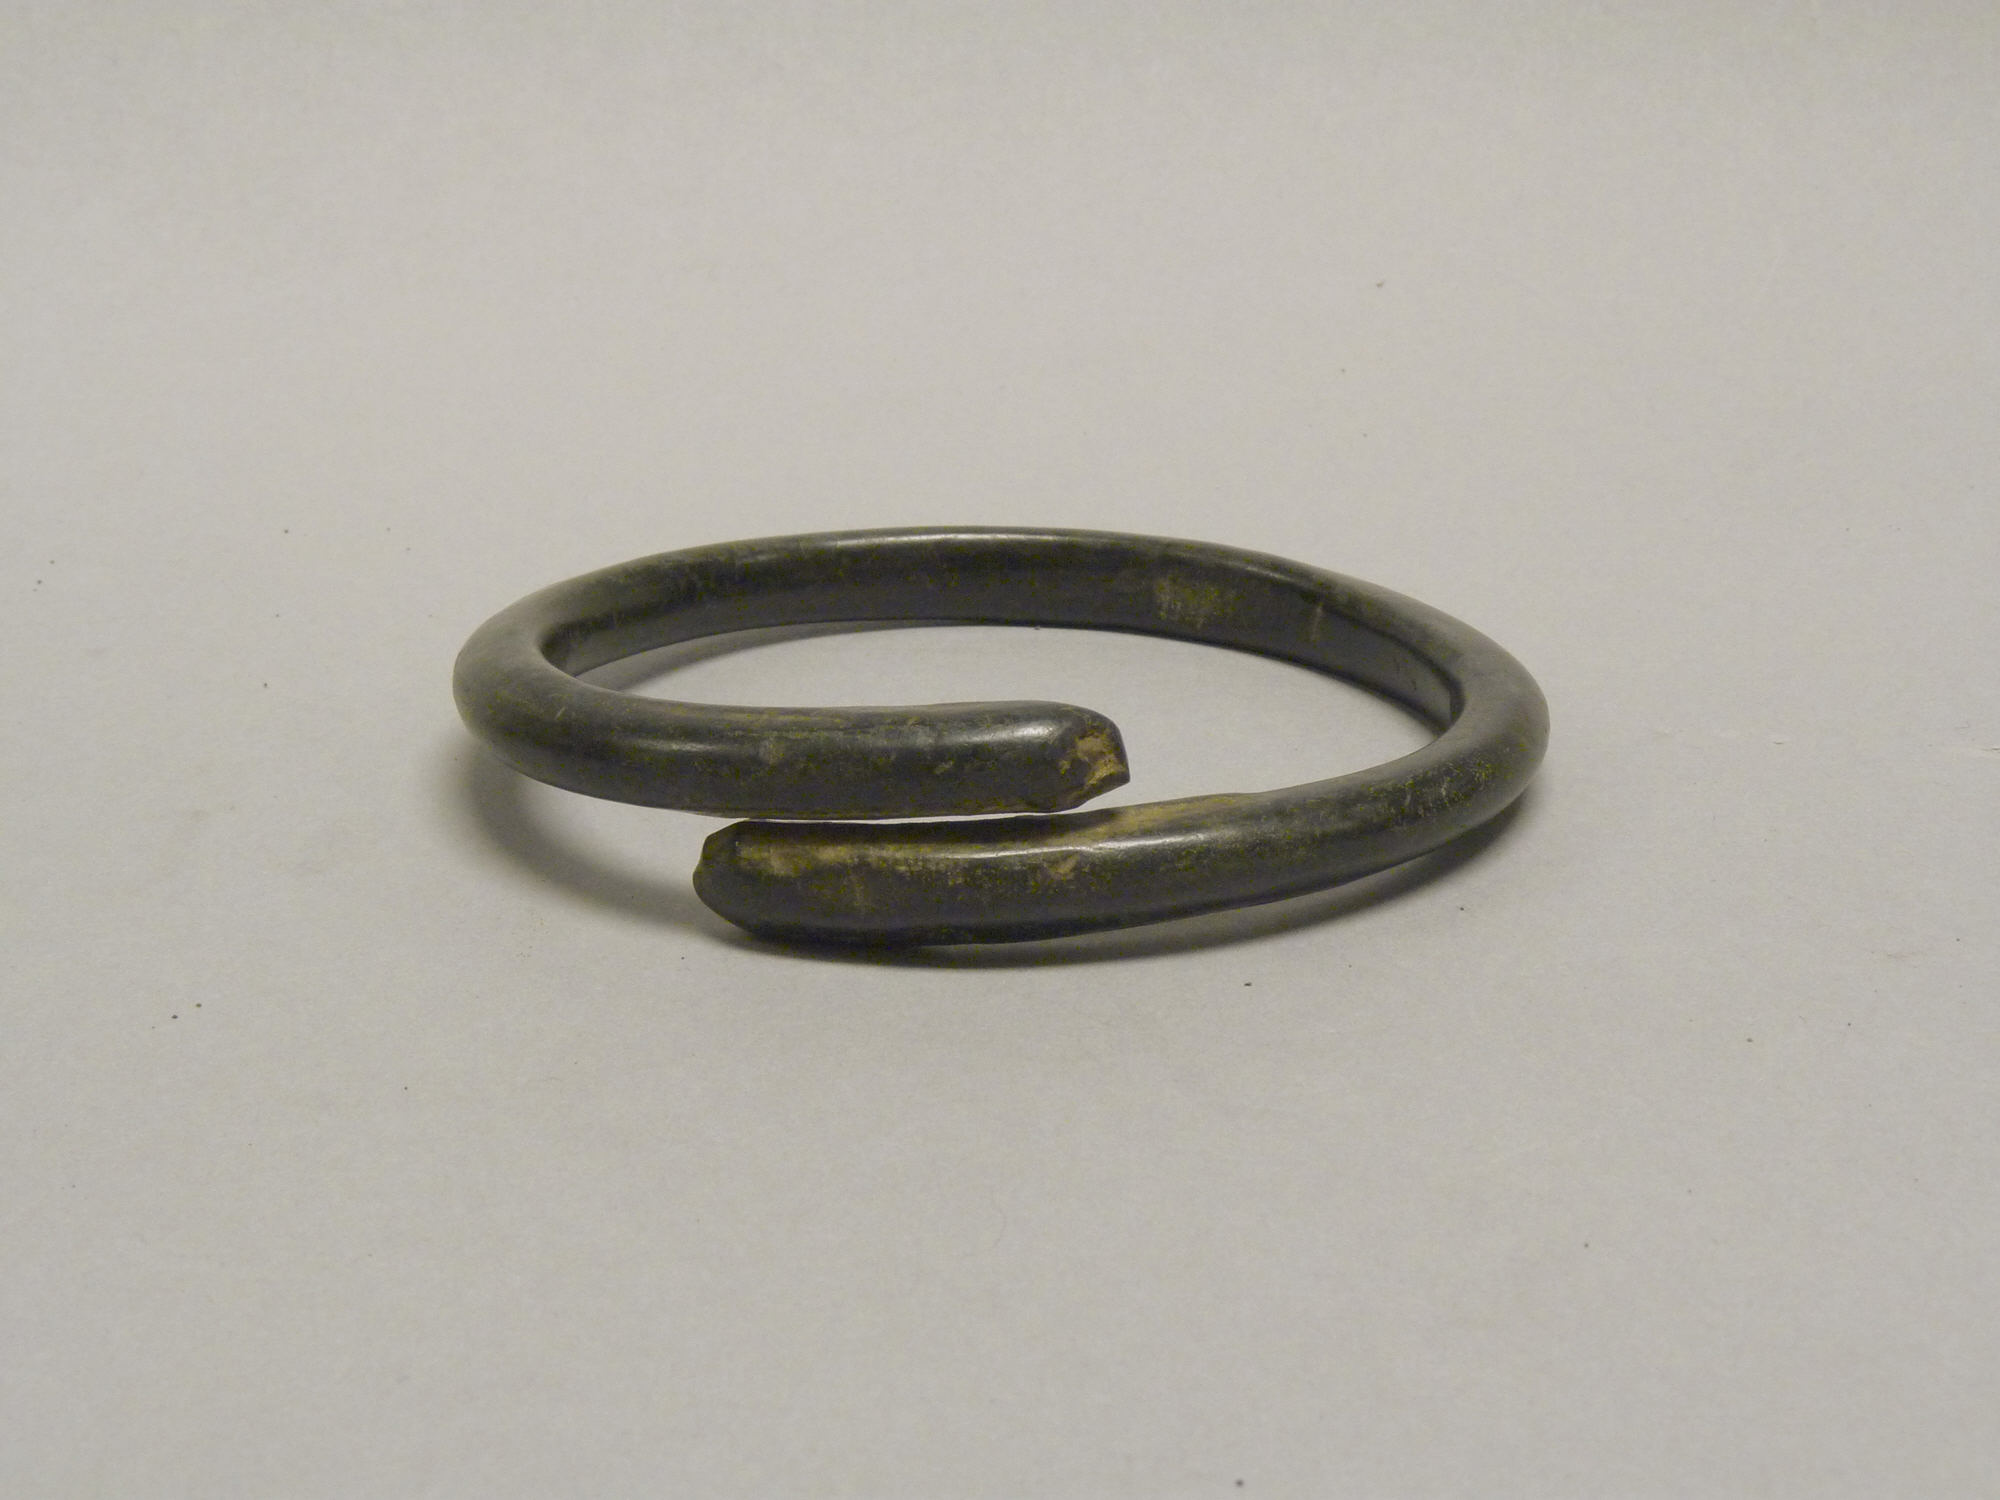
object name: anklet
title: One of a Pair of Overlapping Undecorated Anklets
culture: vietnamese, north, highlands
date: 500 BCE-300 CE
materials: bronze